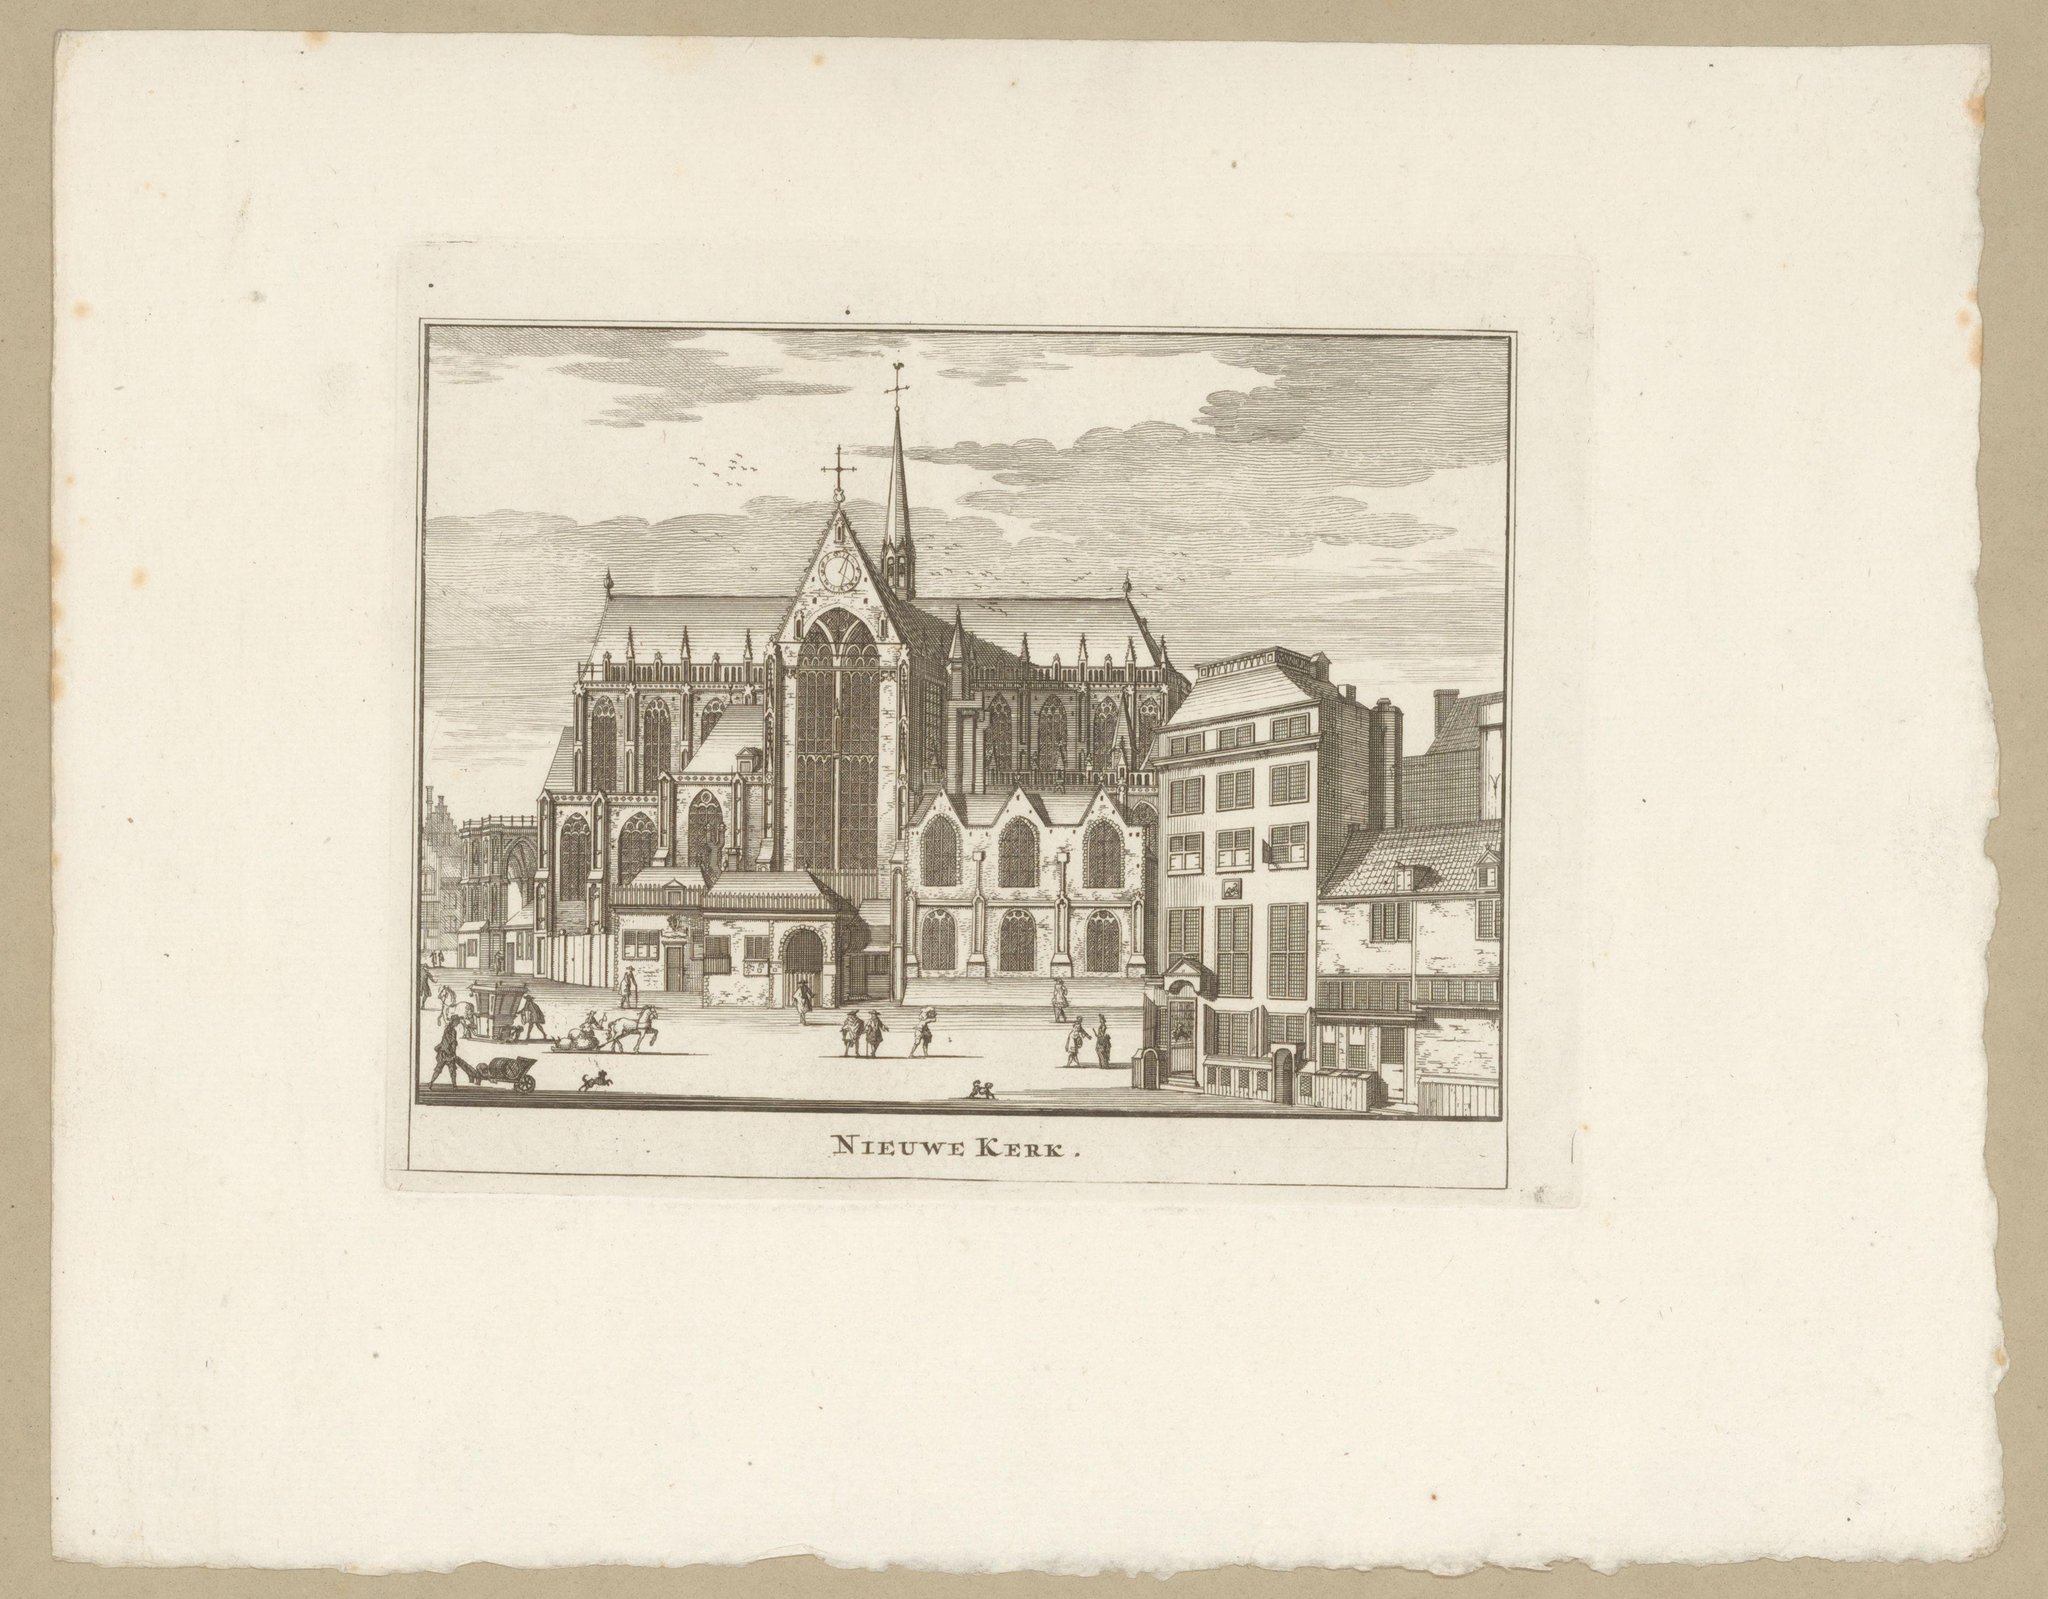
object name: print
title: Nieuwe Kerk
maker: Anonymous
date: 1751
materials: paper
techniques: engraving, etching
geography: northern netherlands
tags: church (exterior), square, place, circus, etc. (+ city(-scape) with figures, staffage)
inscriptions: collector's mark: Lugt 1641b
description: Eerste staat van prent, genummerd 159, gebruikt in: Hoorn, Nicolaas ten. Wegwyzer door Amsterdam zynde eene beknopte verhandeling van desselfs eerste opkomst, vergrootingen, en teegenwoordigen staat (...). Amsterdam: Nicolaas ten Hoorn, 1713. En in: Hoorn, Nicolaas ten. Wegwyzer door Amsterdam zynde eene beknopte verhandeling van desselfs eerste opkomst, vergrootingen, en teegenwoordigen staat (...). Amsterdam: Nicolaas ten Hoorn, 1726. Tweede staat van prent, genummerd 170, gebruikt in: Hoorn, Nicolaas ten. Wegwyzer door Amsterdam zynde eene beknopte verhandeling van desselfs eerste opkomst, vergrootingen, en teegenwoordigen staat (...). Amsterdam: Nicolaas ten Hoorn, 1726. En in: Hoorn, Nicolaas ten. Wegwyzer, of korte beschryvinge van de stadt Amsterdam, zynde eene beknopte verhandeling van desselfs eerste opkomst, vergrootingen, en teegenwoordigen staat (...). Amsterdam: erven J. Ratelband & Co, 1737. En in: Hoorn, Nicolaas ten. Wegwyzer of korte beschryvinge der stad Amsterdam, zynde eene beknopte verhandeling van derzelver eerste opkomst, vergrootingen, en tegenwoordigen staat (...). Amsterdam: Pieter Meyer, 1751.